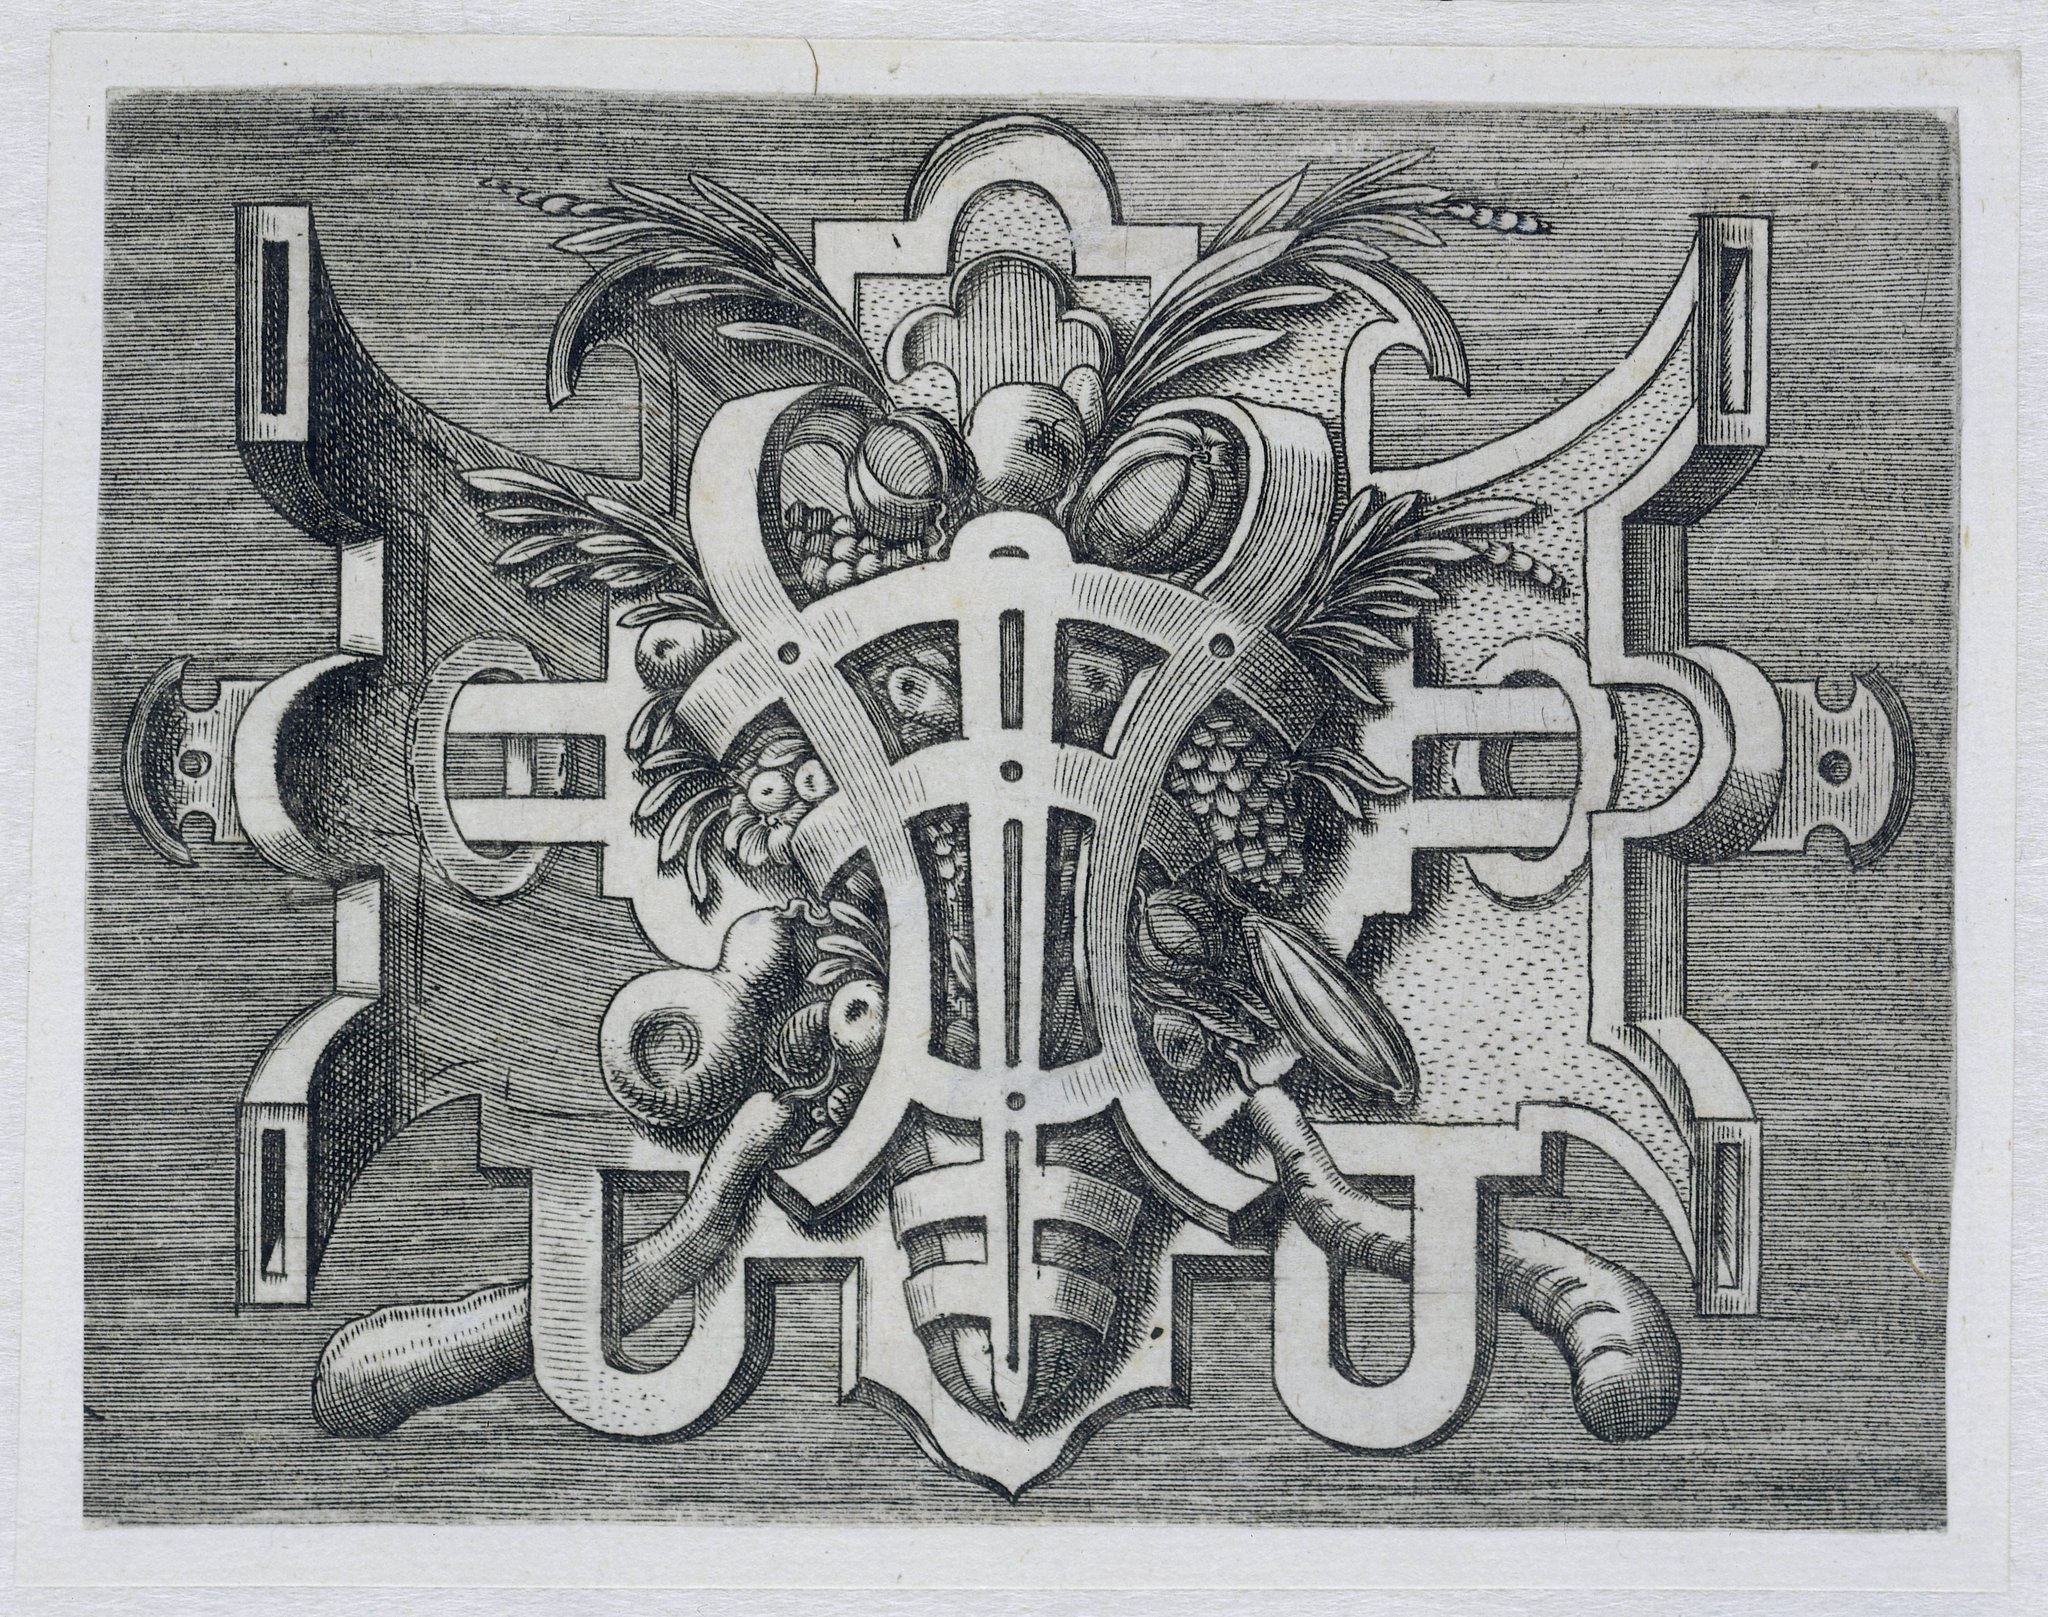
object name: print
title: Cartouches en vazenmotieven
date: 1516-1556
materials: paper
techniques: engraving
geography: netherlands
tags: ornament ~ grotesque, fruits and vegetables ~ ornament, scrollwork, strapwork ~ ornament, vase ~ ornament, ornament ~ cartouche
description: Gearceerde achtergrond. Een van 5 bladen afkomstig uit een serie van 20.